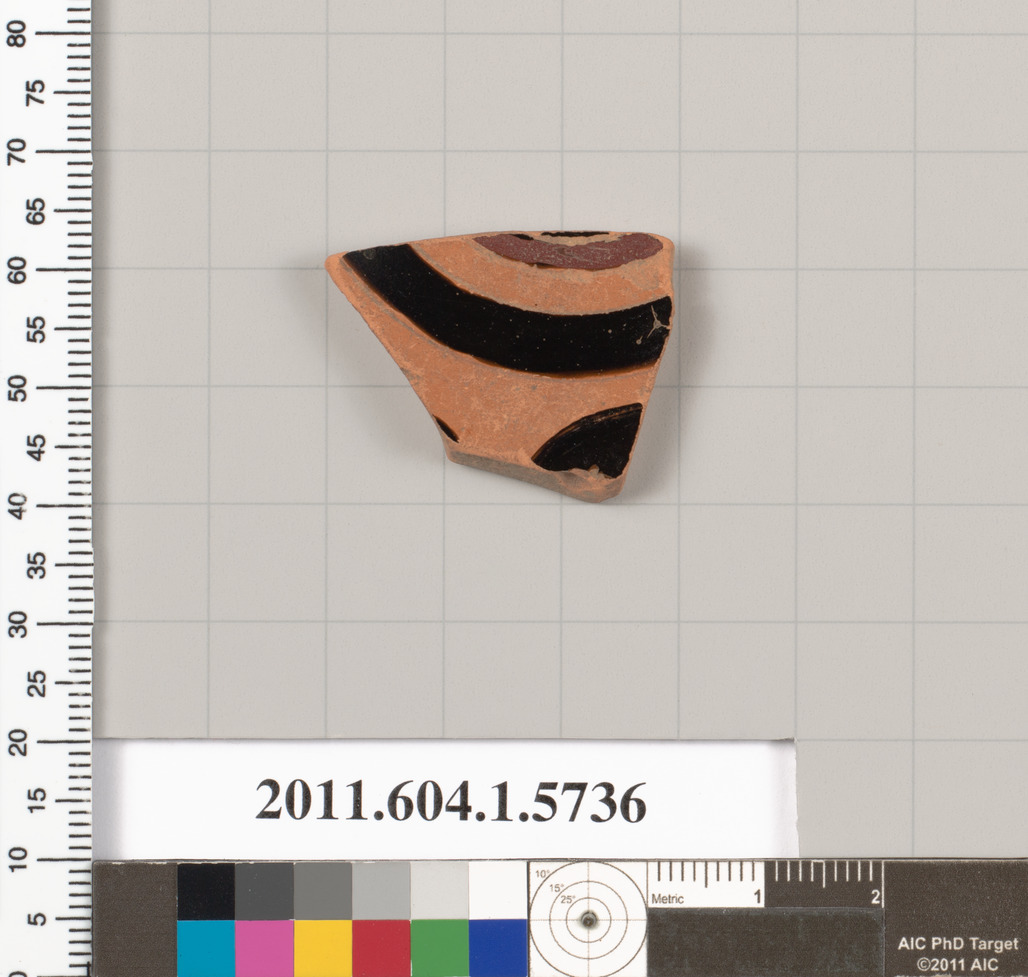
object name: kylix fragment, eye cup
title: Terracotta fragment of a kylix: eye-cup (drinking cup)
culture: greek, attic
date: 525-515 BCE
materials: terracotta